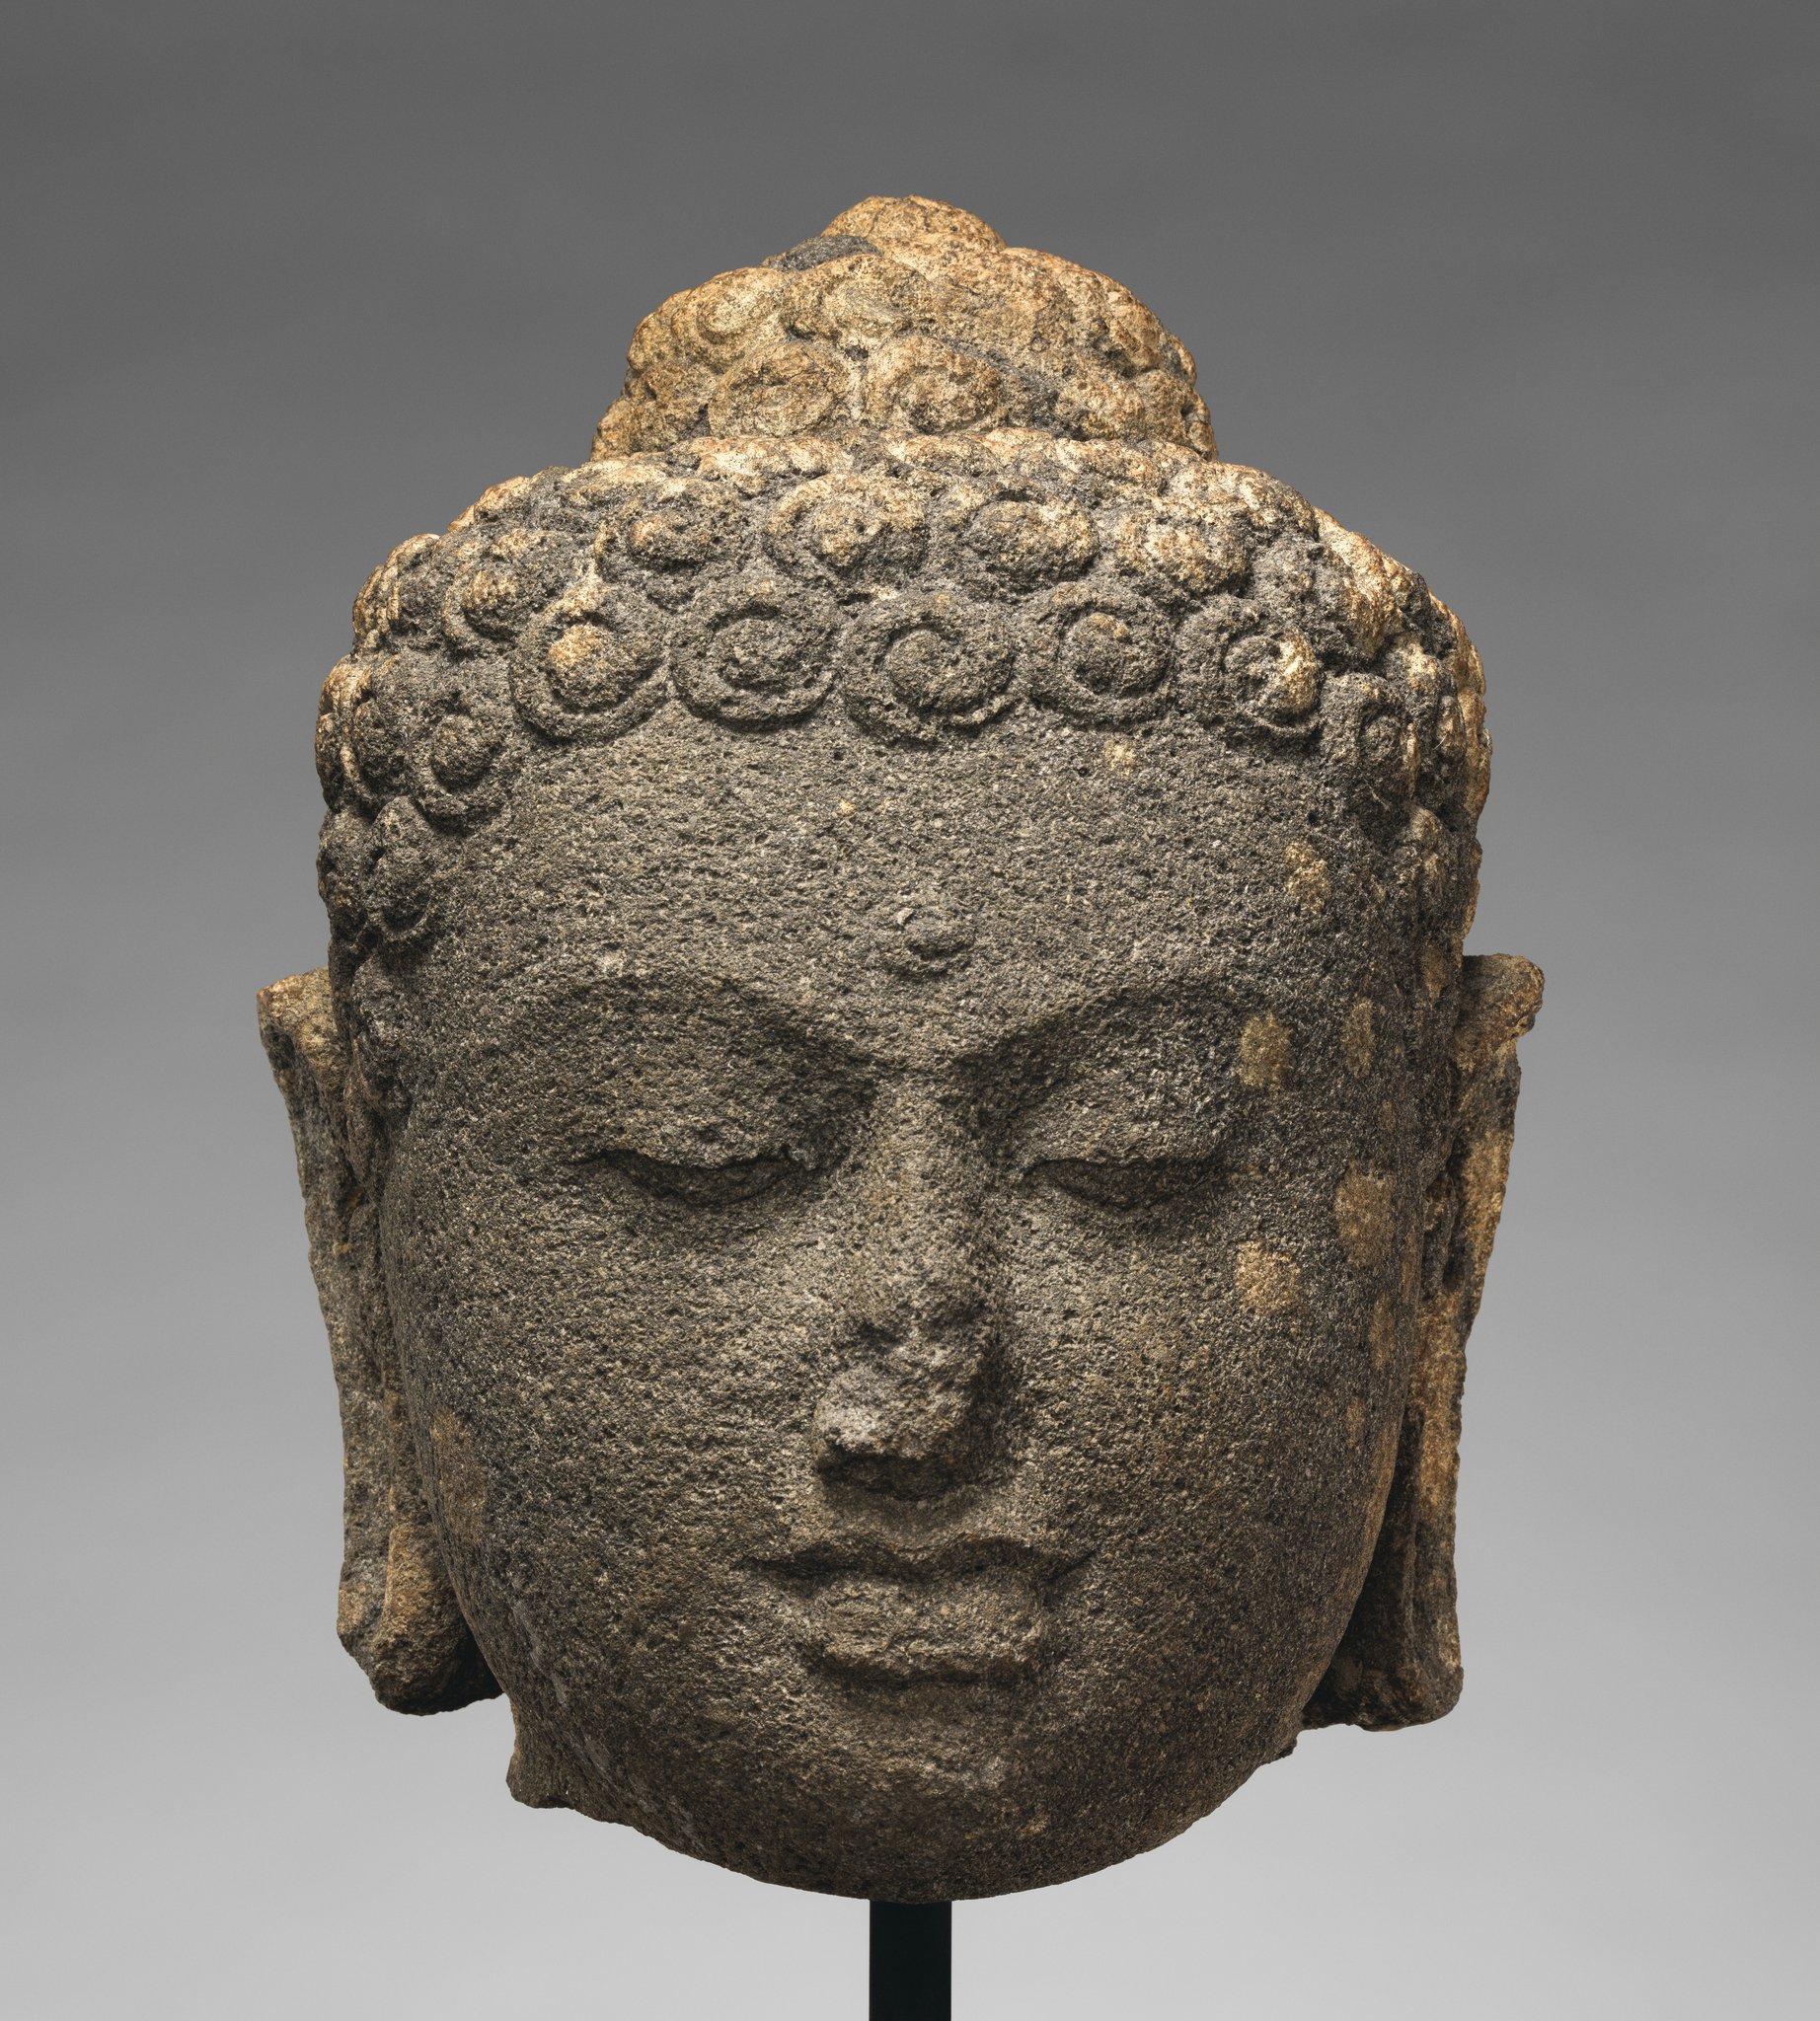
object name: head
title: Head of a Buddha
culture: indonesian, javanese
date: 801-900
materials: stone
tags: heads,buddhism,buddha